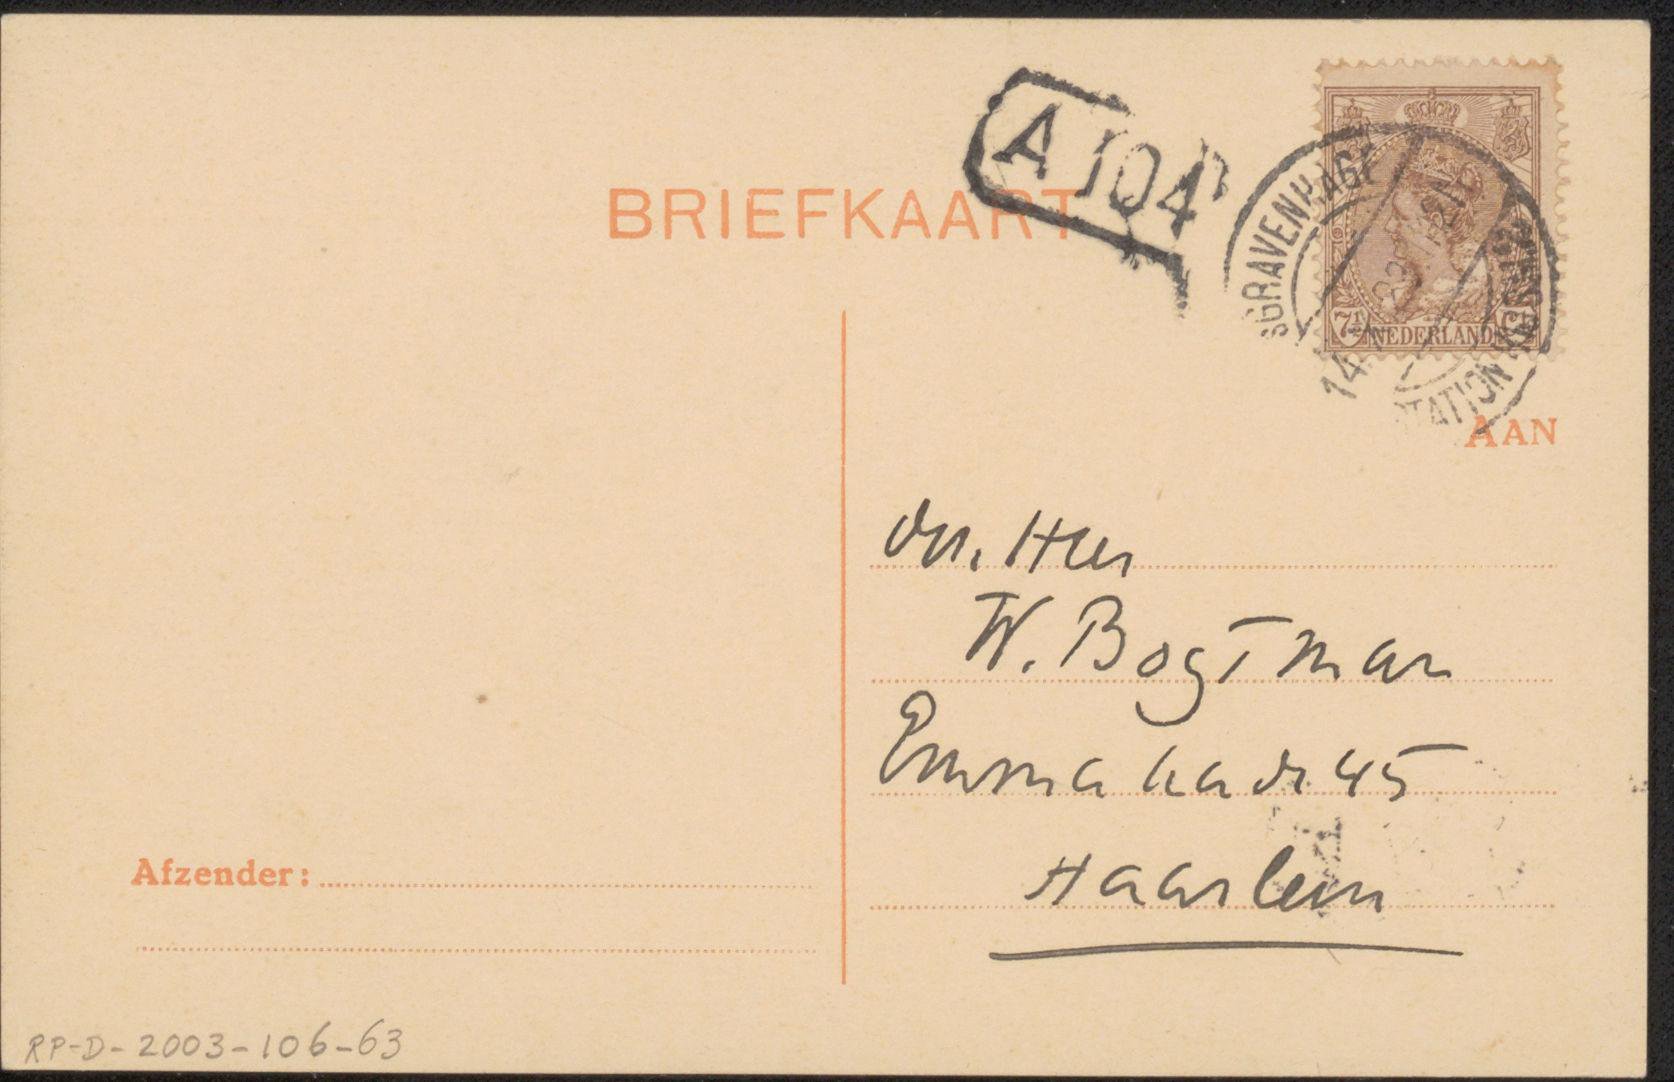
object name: postcard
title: Briefkaart aan Willem Bogtman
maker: richard nicolaüs roland holst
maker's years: 1868-1938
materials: cardboard, pencil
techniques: printing, writing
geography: achtmaal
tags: haarlem, willem bogtman, money